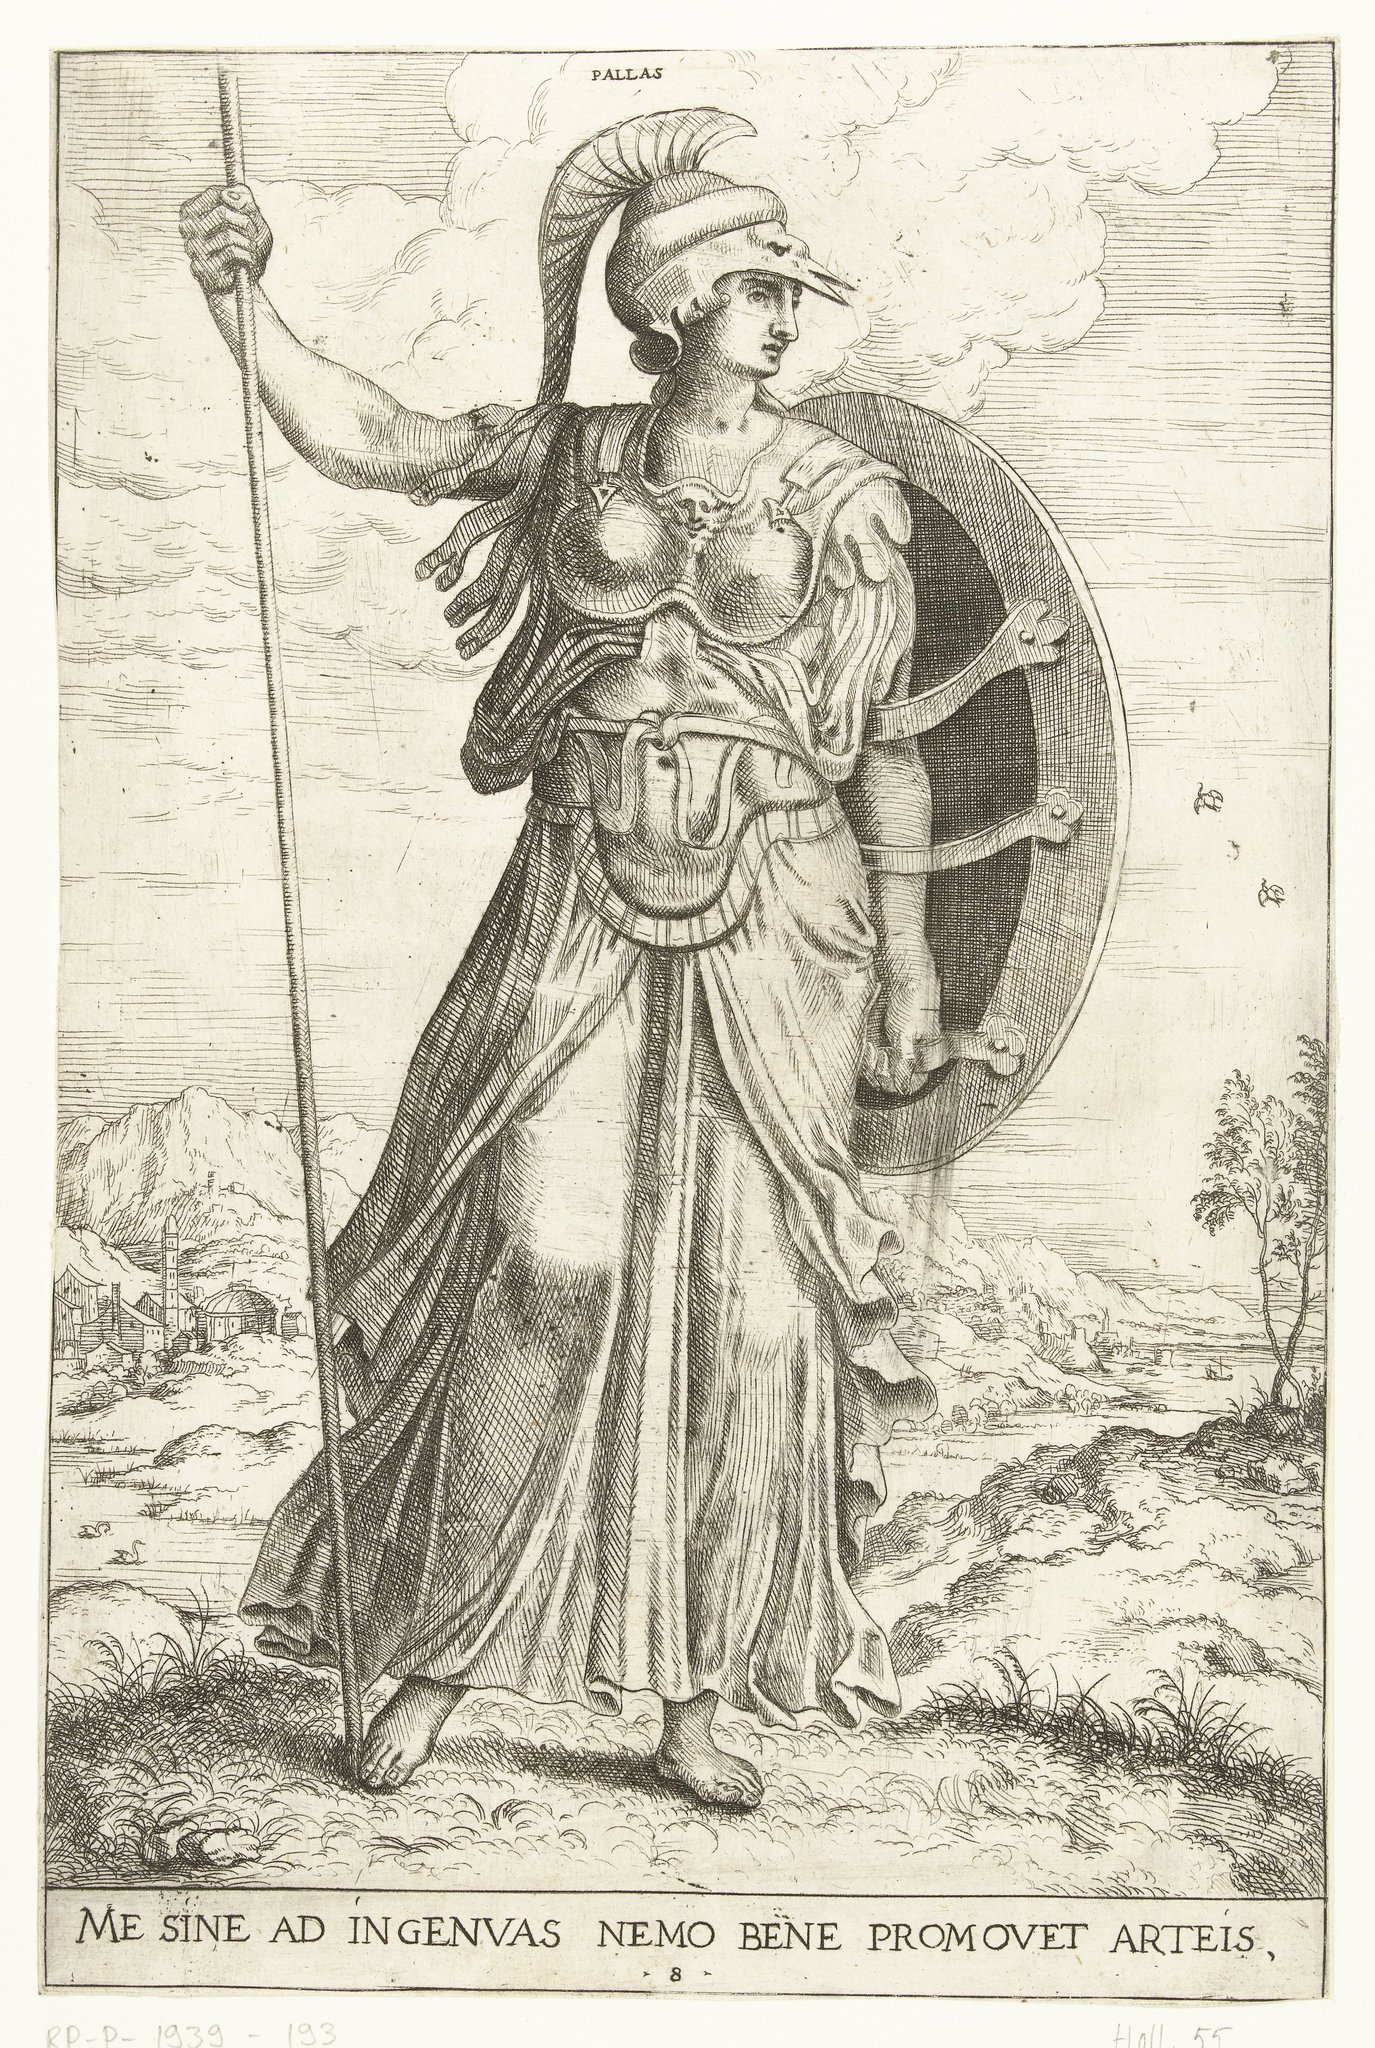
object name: print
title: Pallas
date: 1551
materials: paper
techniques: etching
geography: antwerp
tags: (story of) minerva (pallas, athena) - offspring, companion(s), train etc.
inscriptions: collector's mark: Lugt 2228, collector's mark: Lugt 2760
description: Volgens de literatuur is deze serie een gemeenschappelijk product van Hieronymus Cock en Frans Floris. Waarschijnlijk was Floris verantwoordelijk voor de figuren en Cock voor de landschappen op de achtergrond. Op de tweede prent uit deze serie, Dialectica, bevindt zich echter een nog onbekend monogram (HIV), het is onduidelijk welke rol de onbekende monogrammist heeft gespeeld bij het tot stand komen van de serie.